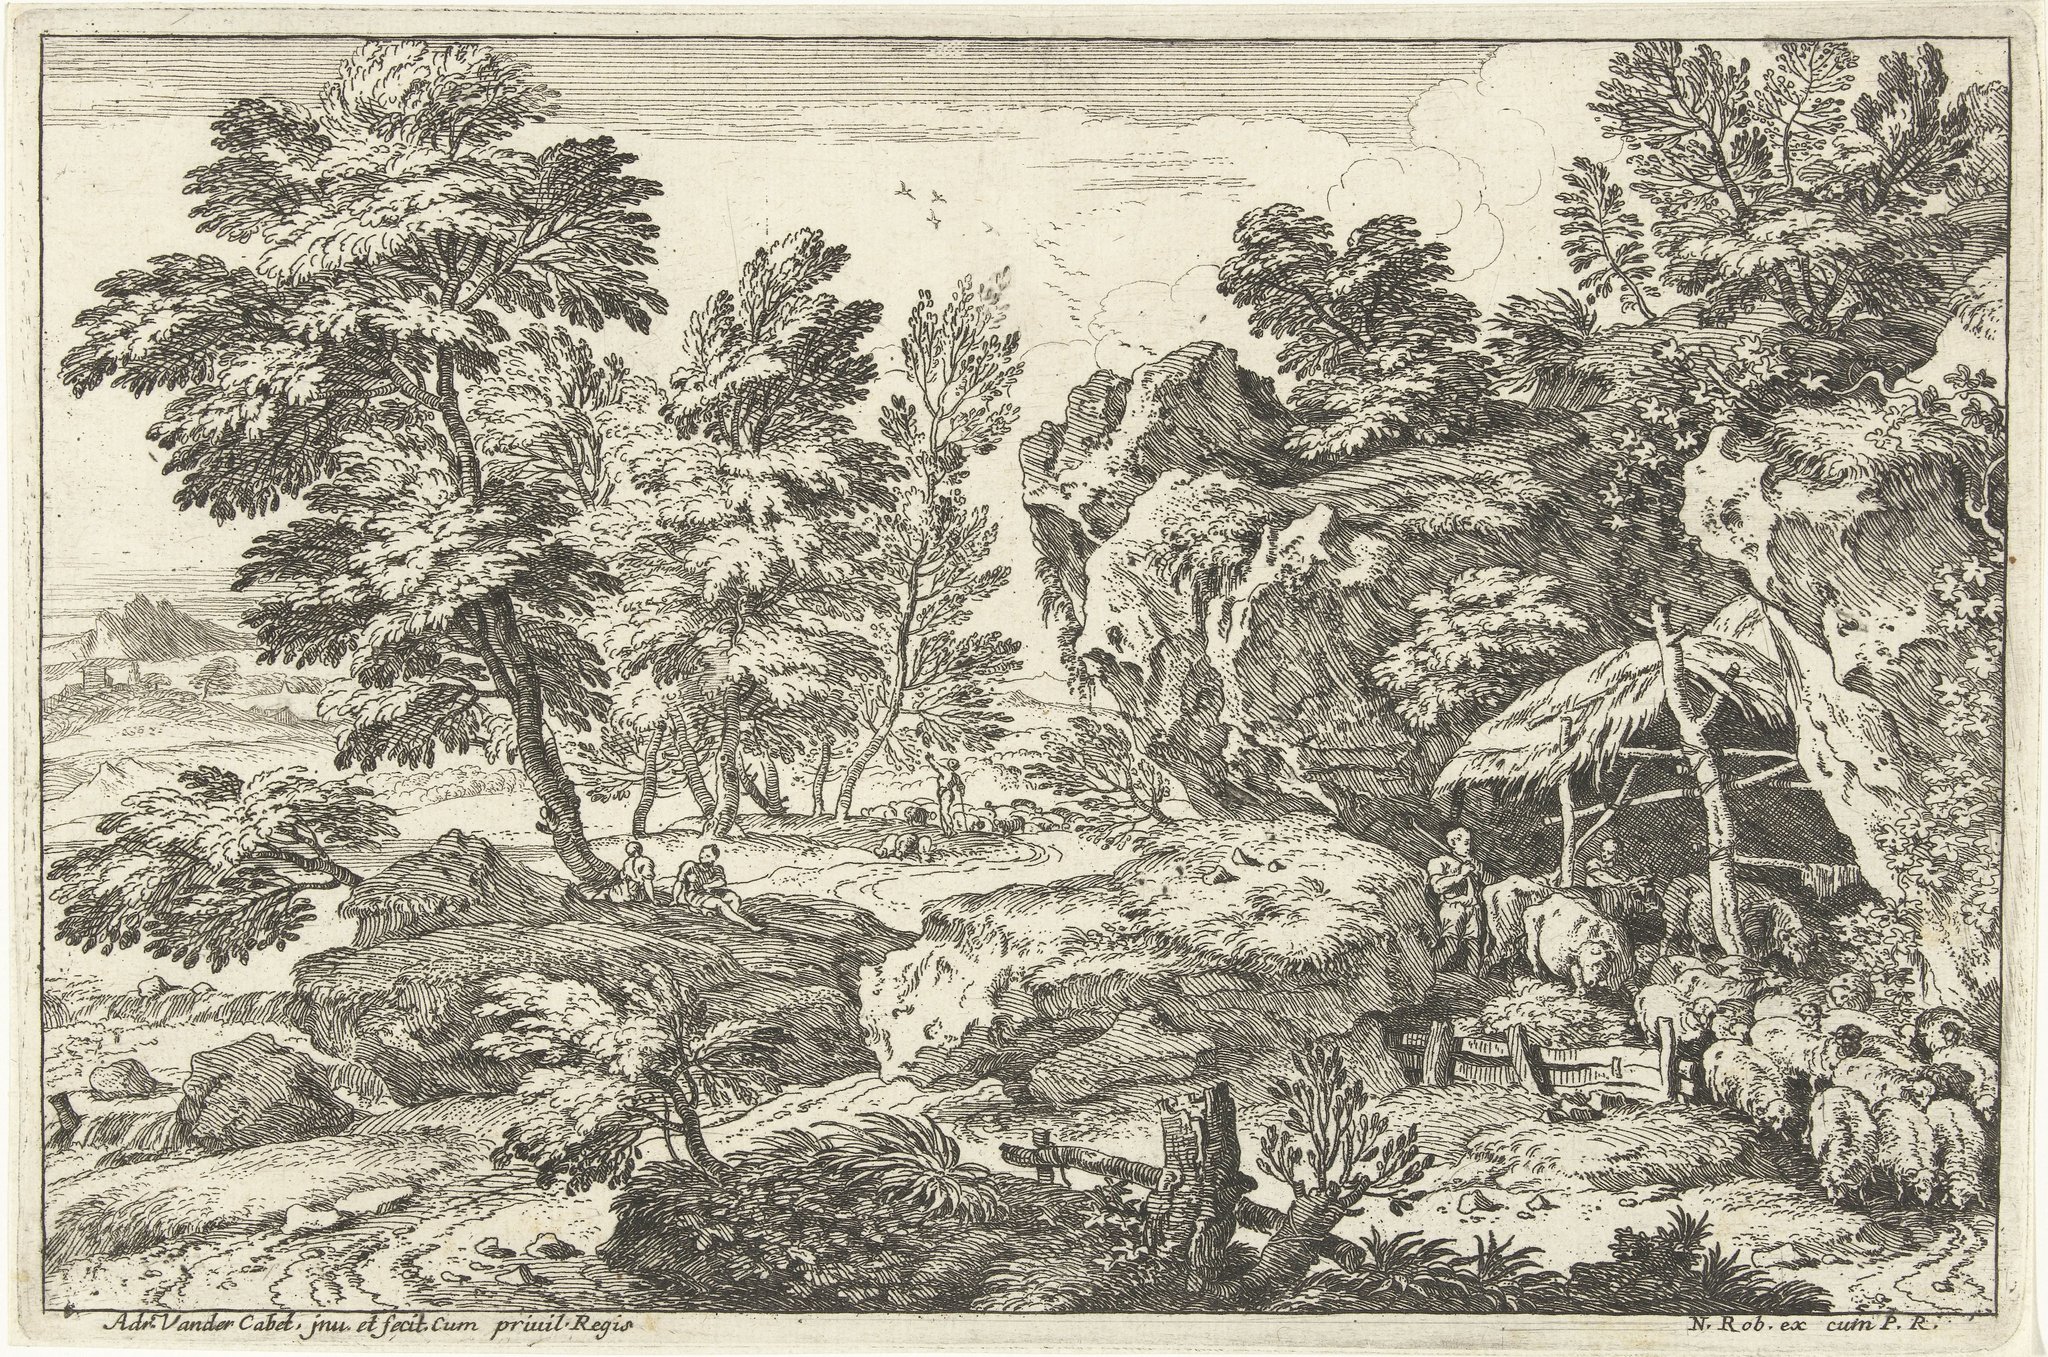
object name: print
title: Landschap met schaapskooi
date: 1648-1705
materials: paper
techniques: etching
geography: france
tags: landscapes, herding, herdsman, herdswoman, shepherd, shepherdess, cowherd, etc.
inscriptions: collector's mark: Lugt 240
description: Landschap met op de voorgrond, rechts, een schaapskooi met de herder staand bij enkele koeien, terwijl de schapen de kooi verlaten. Eerste prent uit de serie van zes.